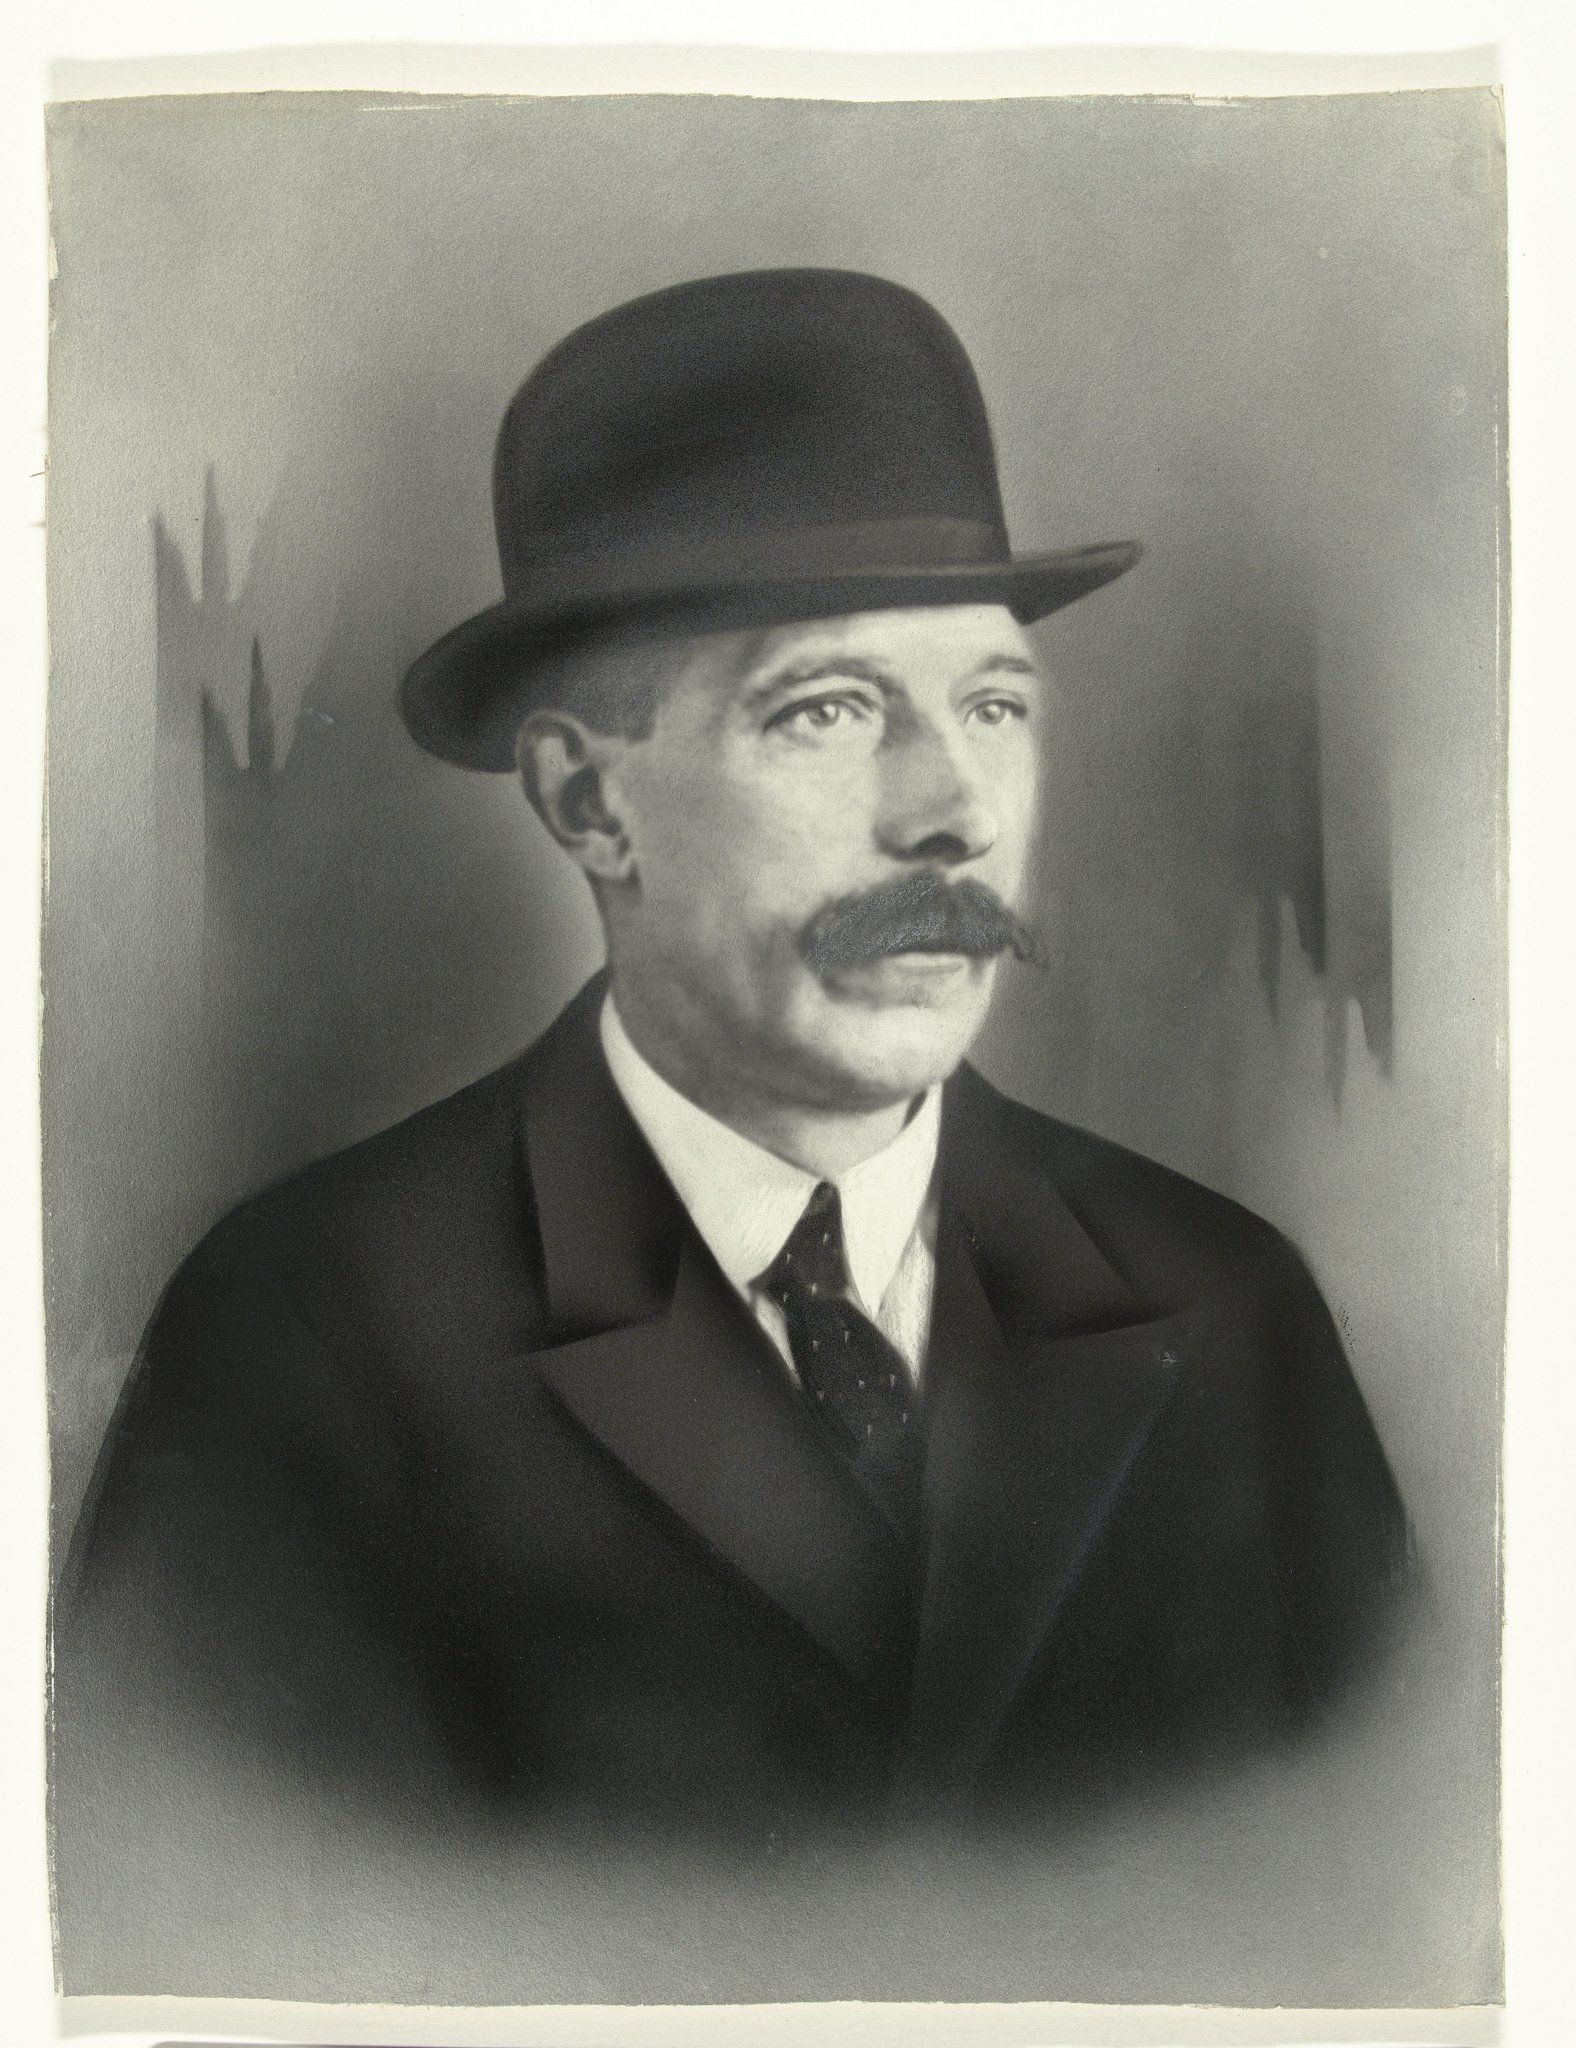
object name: photograph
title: Ingekleurd portret van een man met snor en bolhoed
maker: ceko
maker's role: fotograaf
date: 1920-1940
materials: paper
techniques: gelatin silver print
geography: amsterdam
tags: historical persons not known by name, netherlands